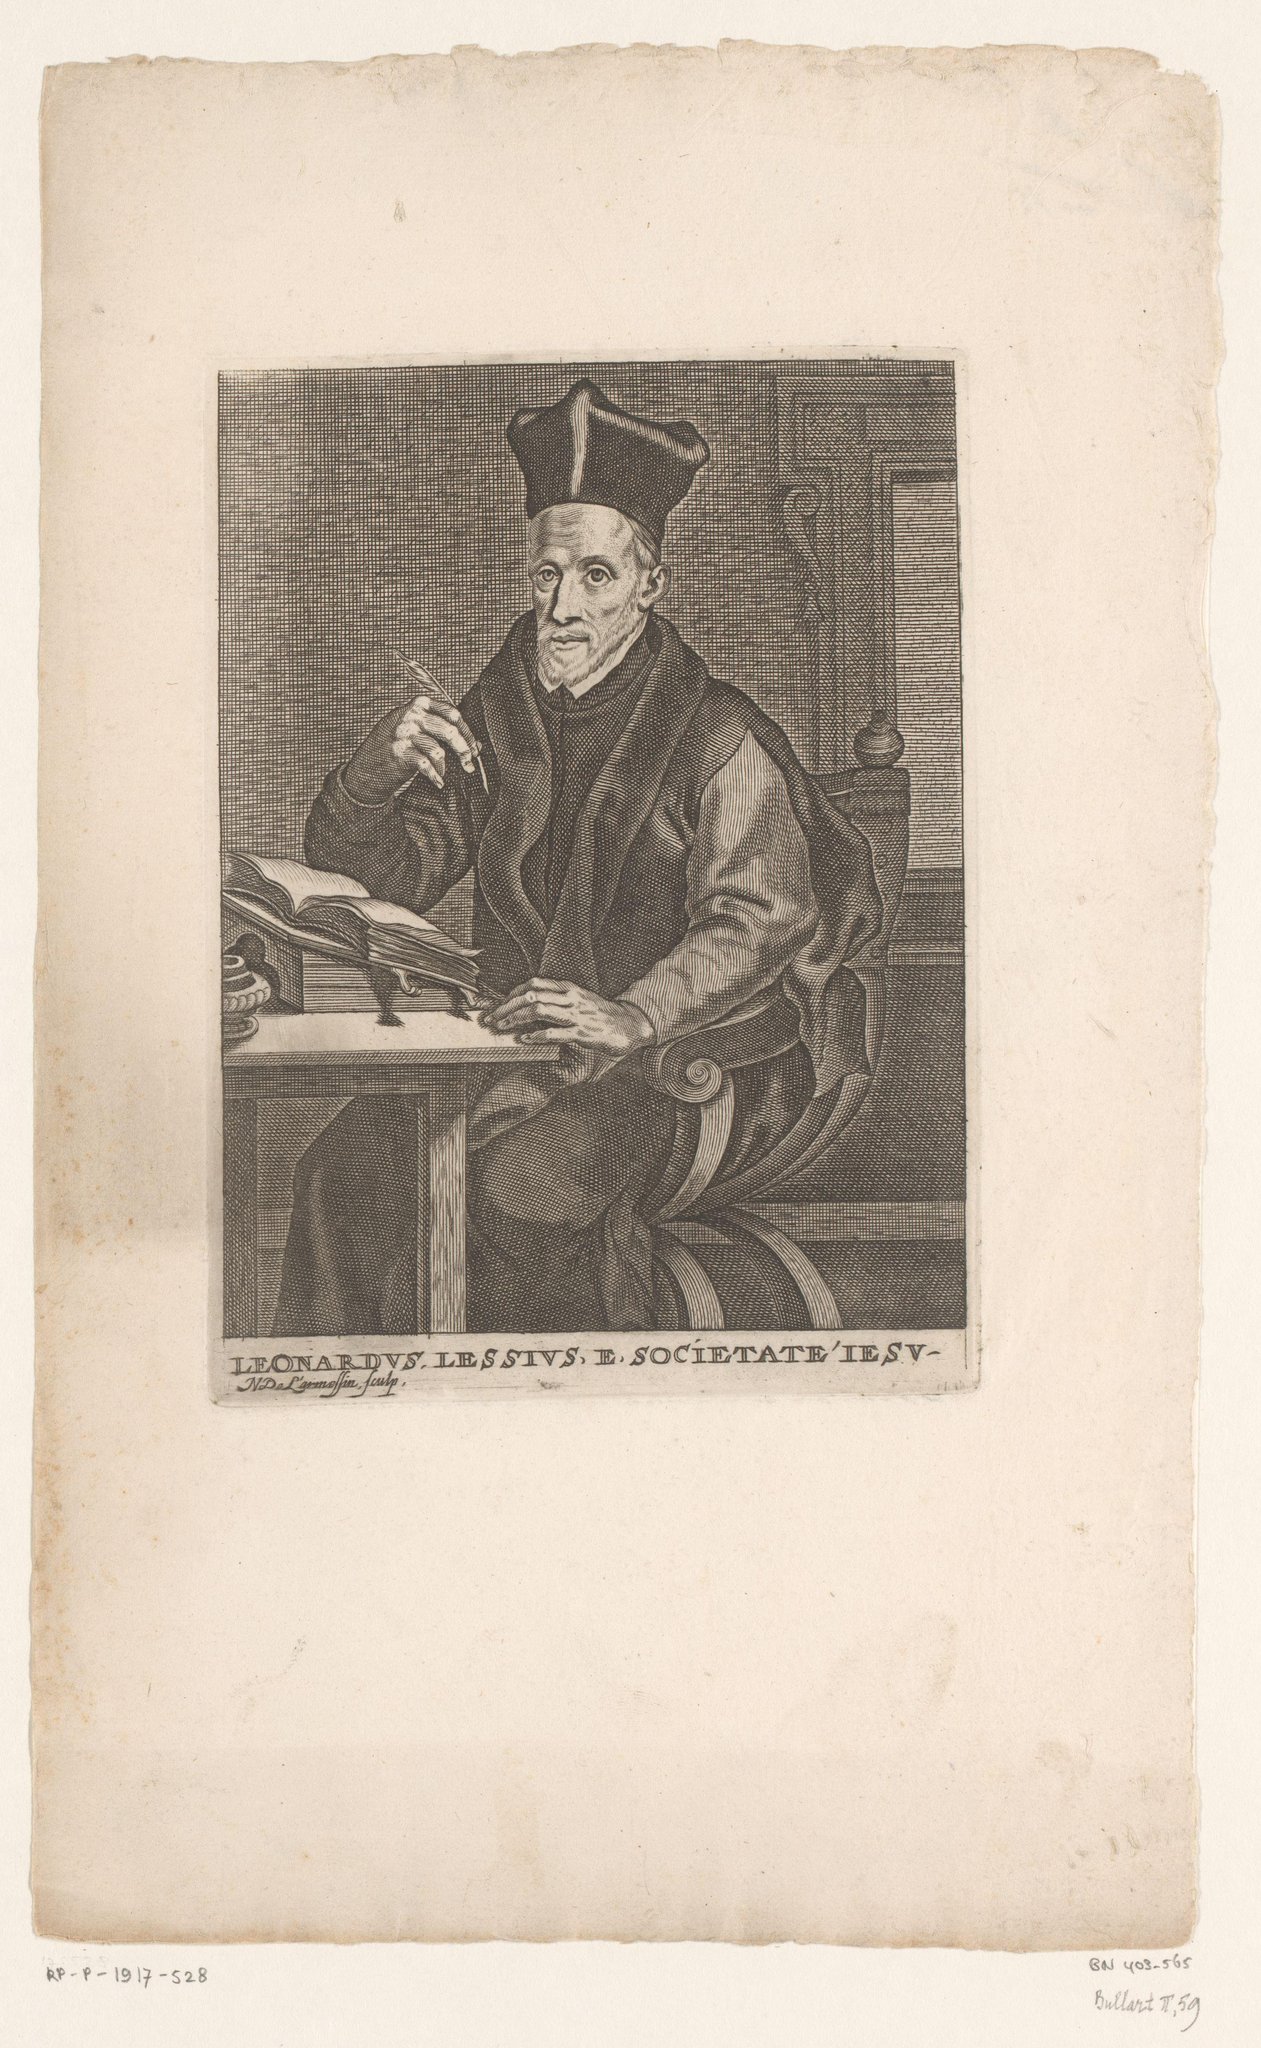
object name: print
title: Portret van Leonardus Lessius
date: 1682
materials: paper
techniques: engraving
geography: brussels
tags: louvain, historical persons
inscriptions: collector's mark: Lugt 2228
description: Prent gebruikt voor: Bullart, Isaac. Académie des Sciences et Arts contenant les vies et éloges his. des hommes illustres qui ont excellé en ces professions depuis environ quatre siècles. Brussel: François Foppens, 1682. Het boek werd in 1682 eveneens in Amsterdam uitgegeven door de erfgenamen van Daniel Elzevier. Ieder portret betreft een illustratie bij de biografie van een kunstenaar of geleerde. De meeste portretten werden door Nicolas de Larmessin vervaardigd (162), 93 door De Boulonois en een derde door ongeïdentificeerde prentmakers. Dit betreft een illustratie op p. 59, deel II.